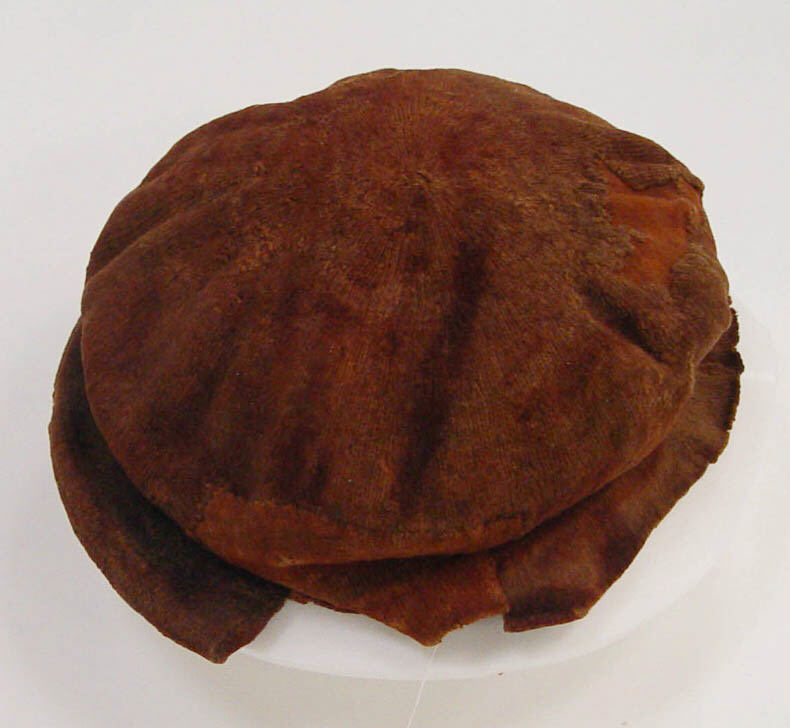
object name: cap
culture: british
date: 1520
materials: wool